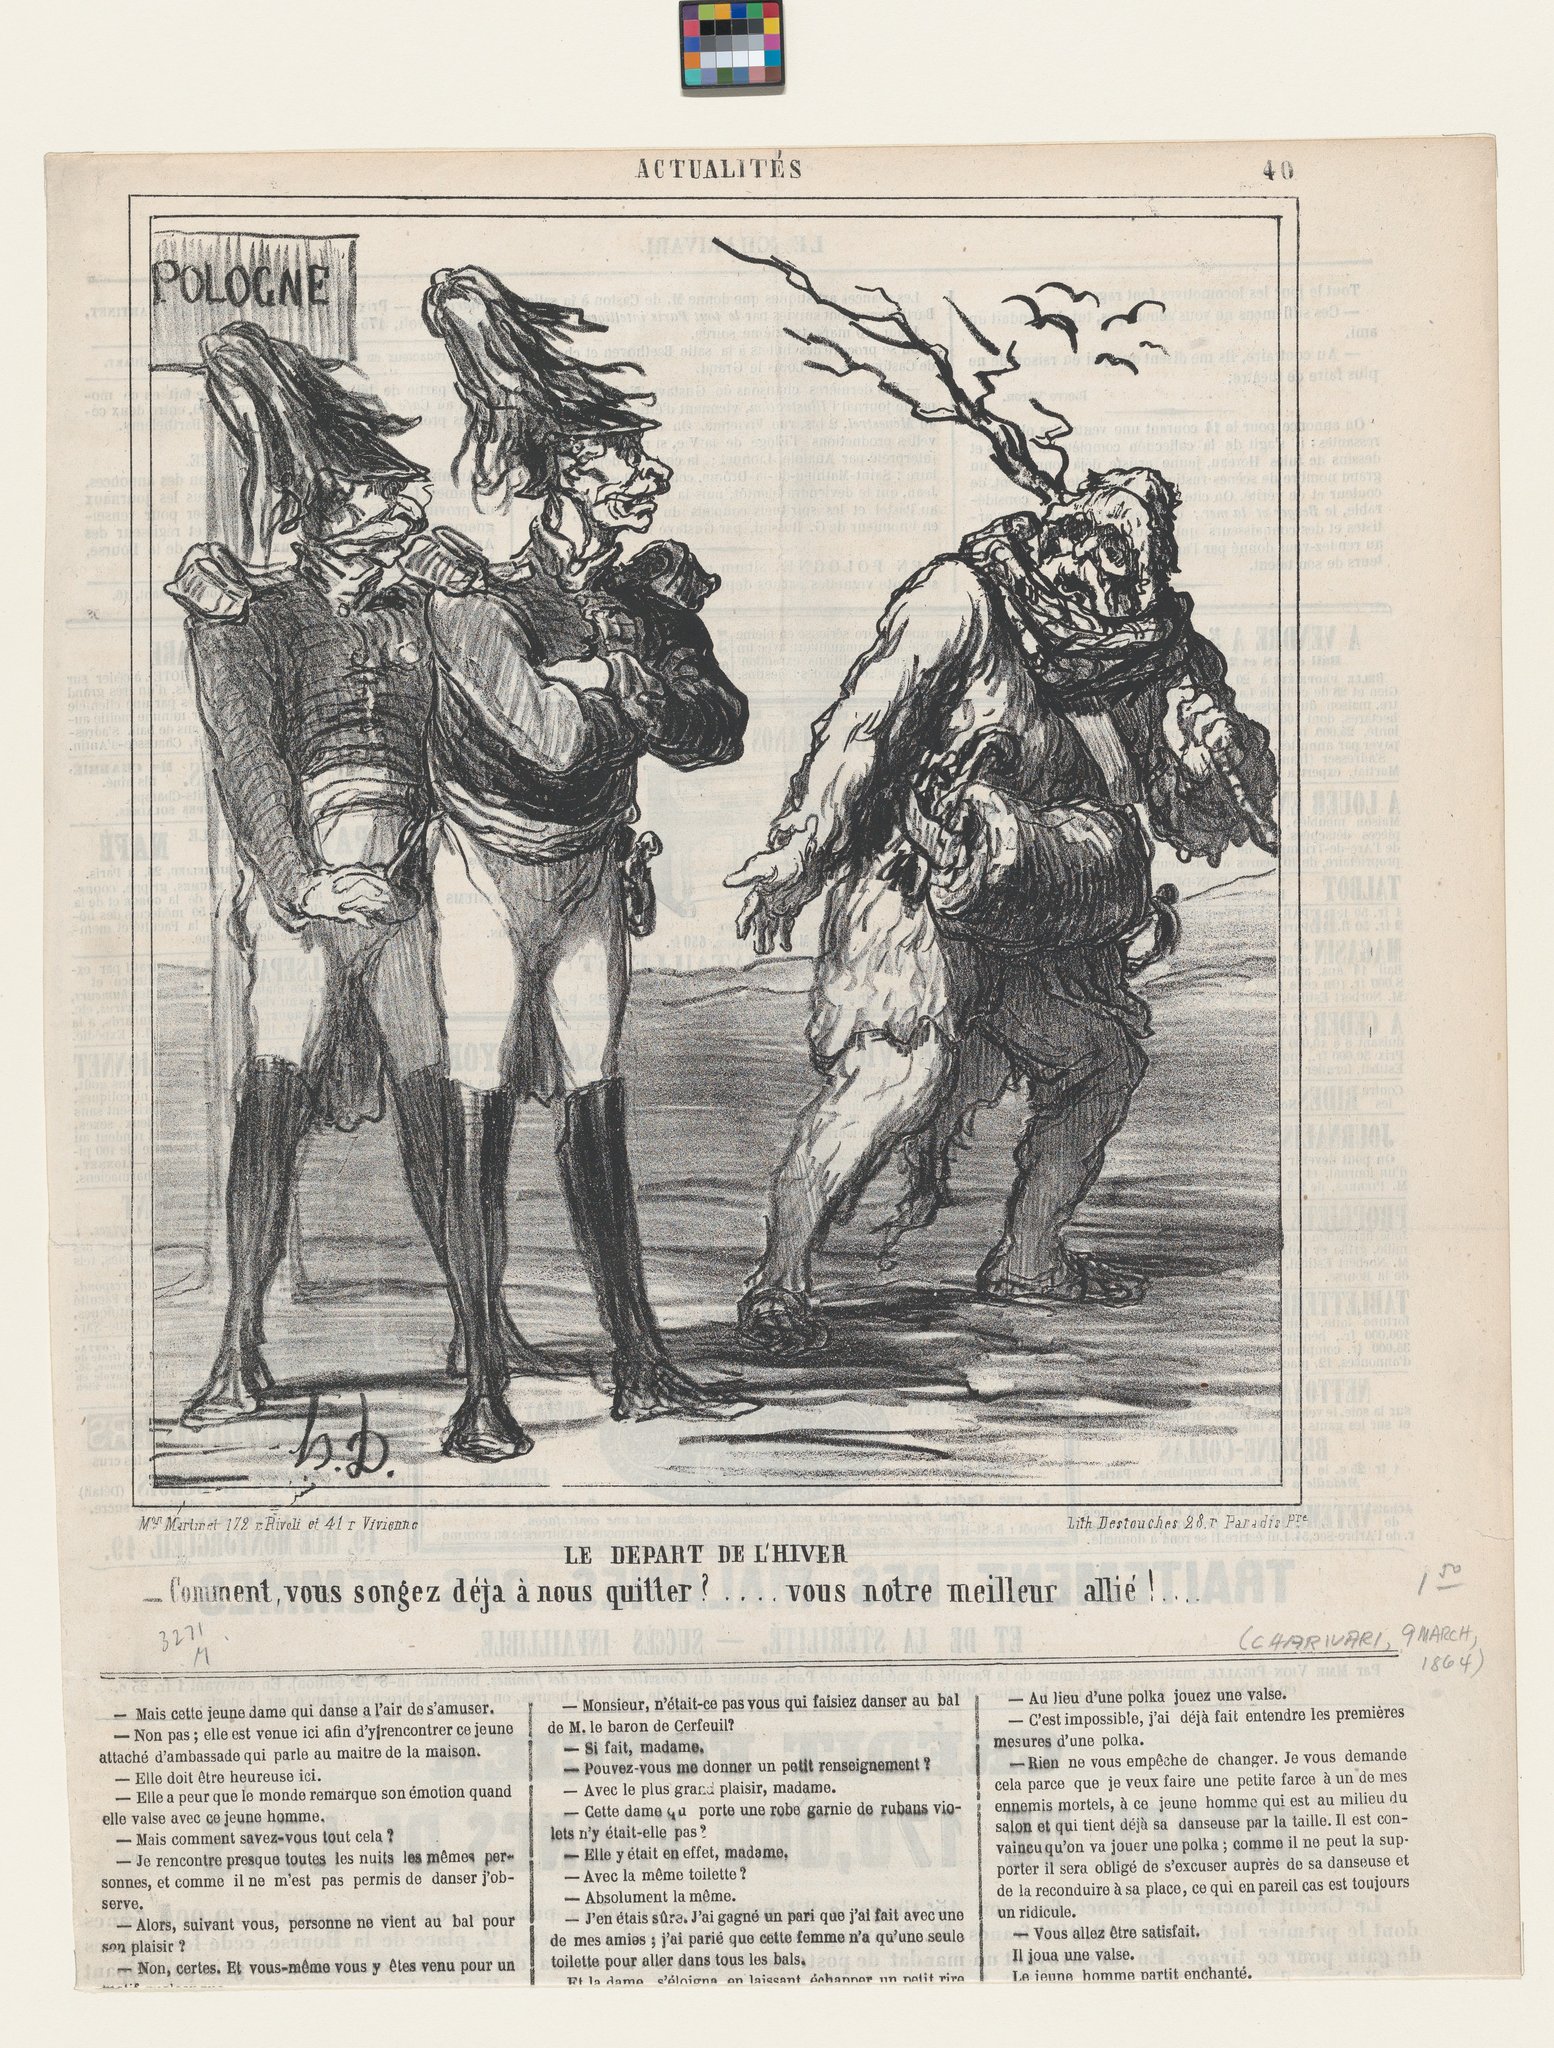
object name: print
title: Winter's departure, from 'News of the day,' published in Le Charivari, March 9, 1864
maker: honoré daumier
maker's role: artist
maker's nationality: french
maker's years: 1808-1879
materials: paper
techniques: lithograph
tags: satire,soldiers,men